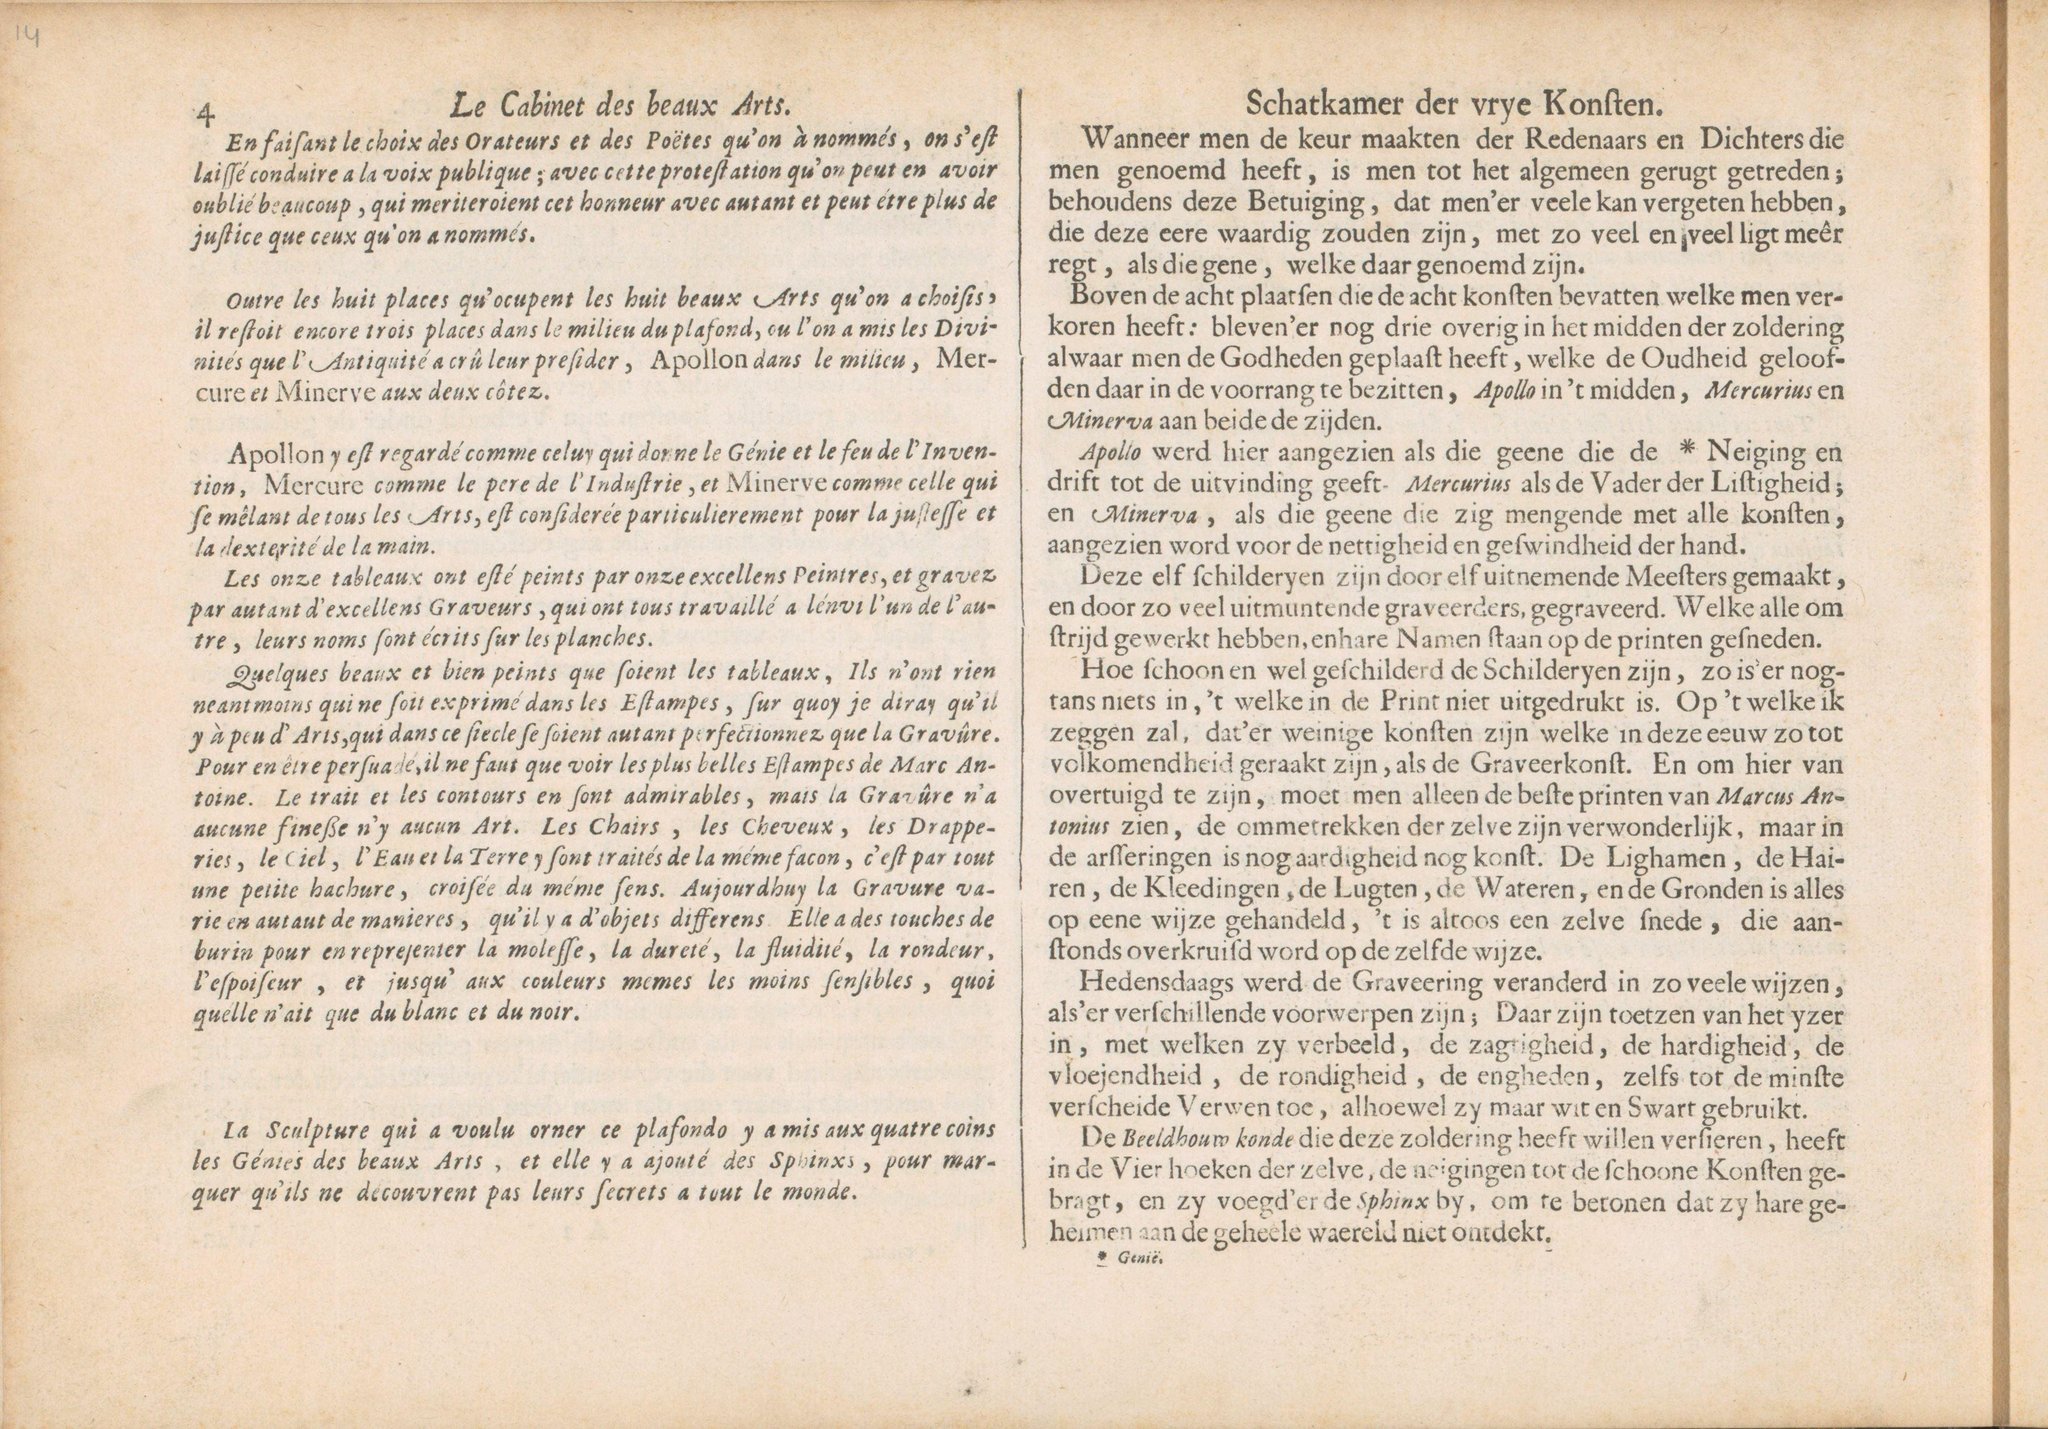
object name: text sheet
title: Verklaring van de prenten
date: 1693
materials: paper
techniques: letterpress printing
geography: amsterdam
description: Verklaring van de prenten in het Frans en het Nederlands, pagina 4. Tekstblad maakt deel uit van een album.